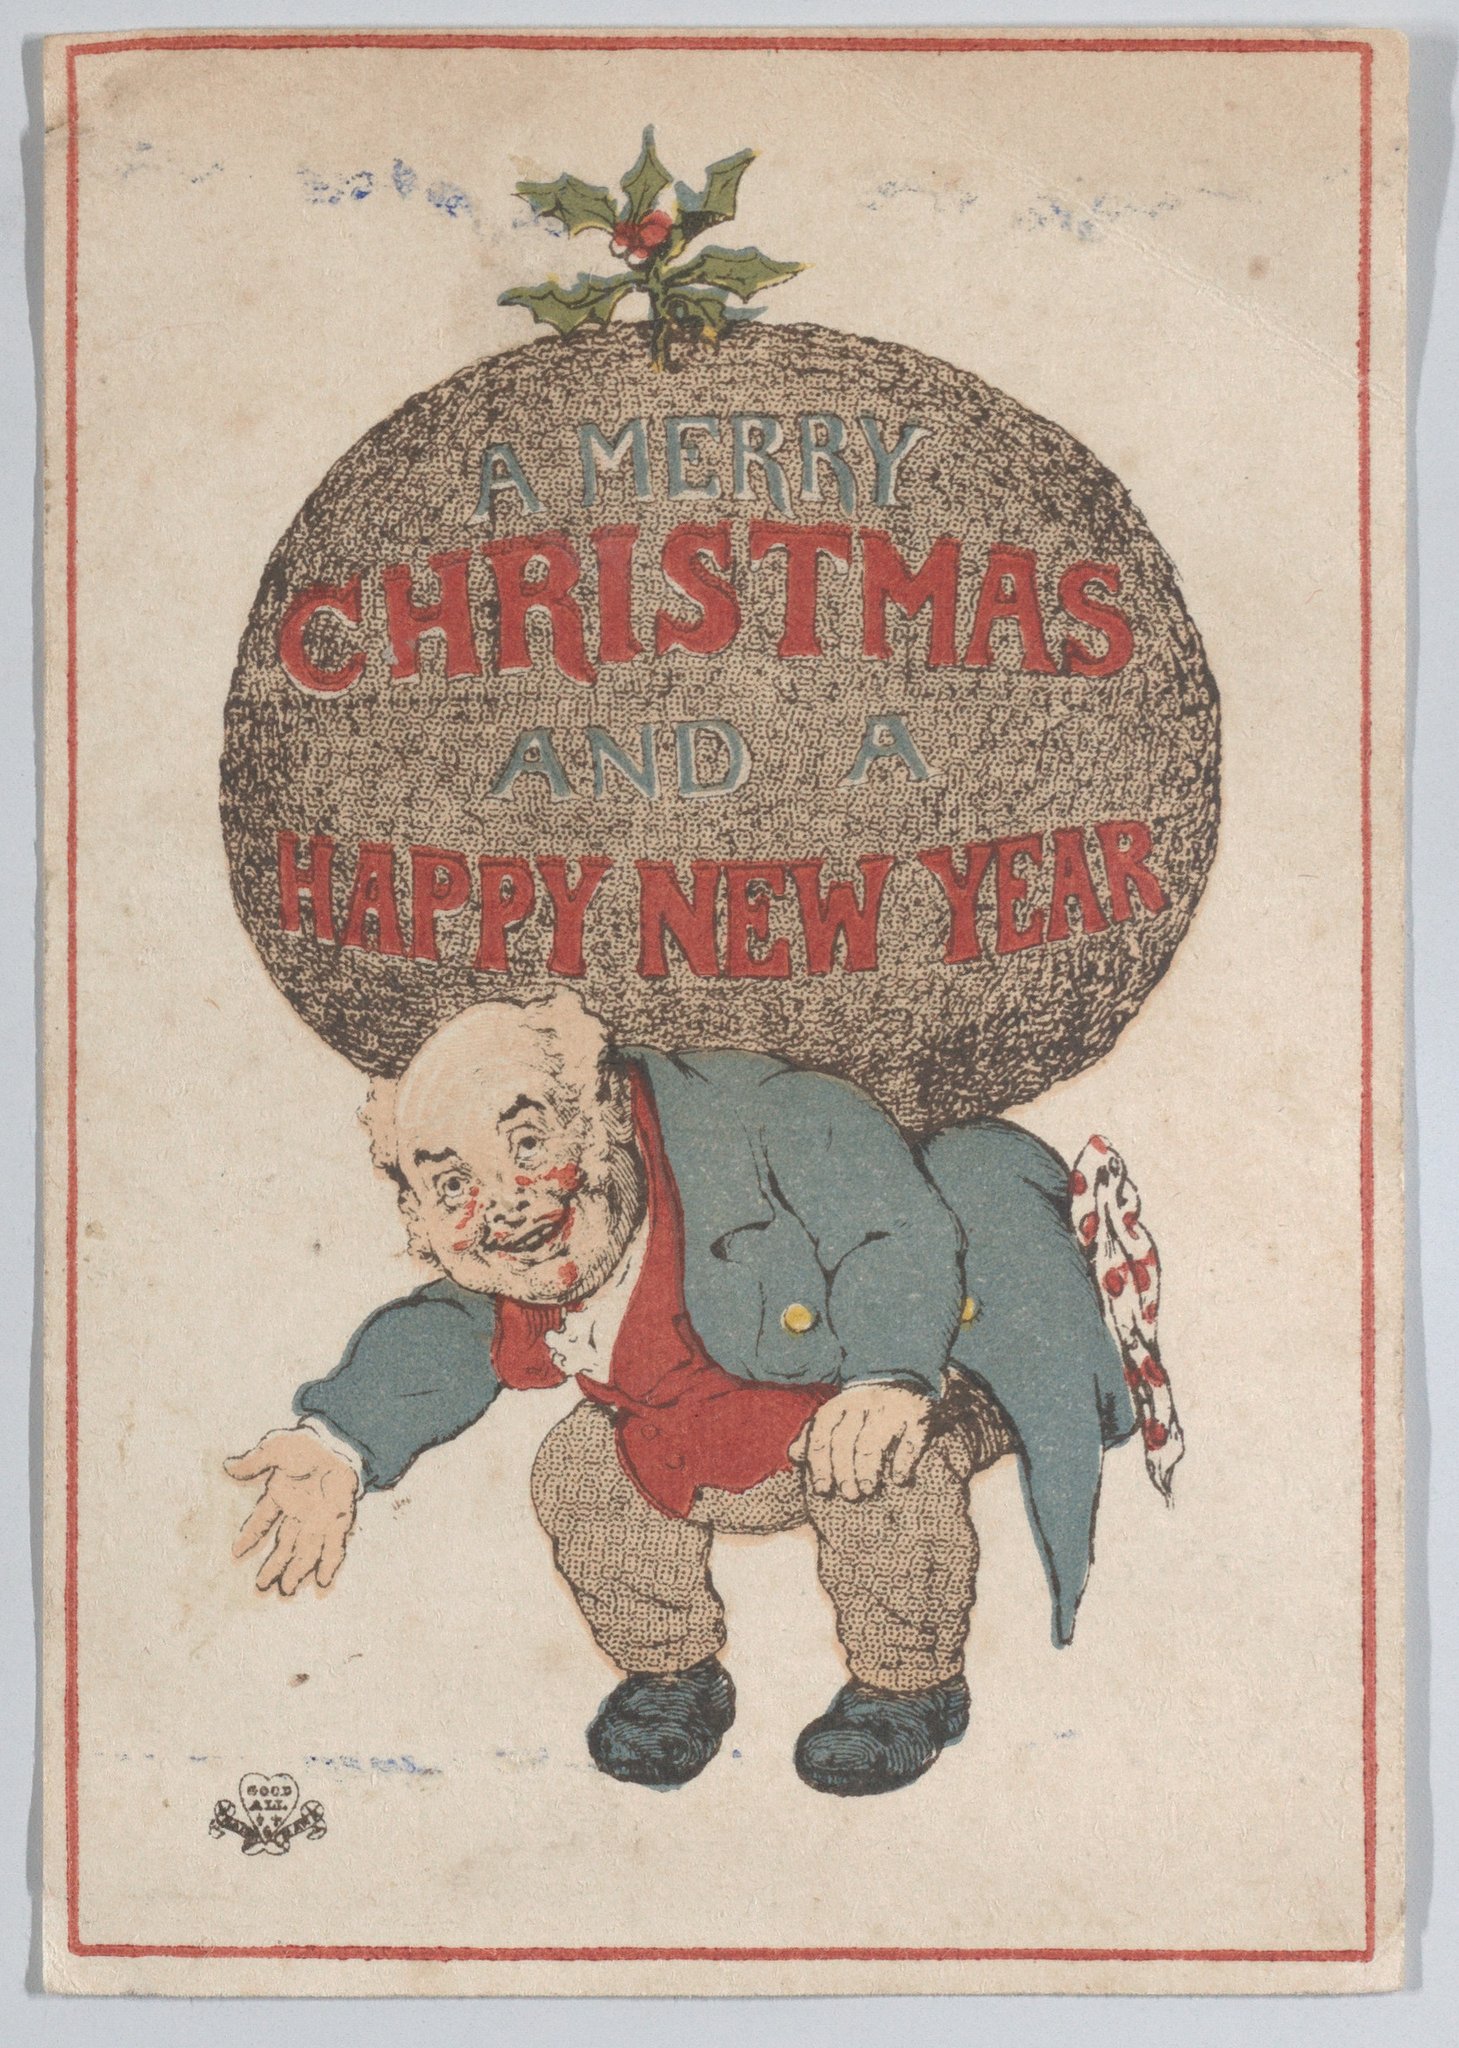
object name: valentine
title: Greeting Card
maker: charles henry bennett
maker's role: artist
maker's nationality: british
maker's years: 1828-1867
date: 1866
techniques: chromolithography